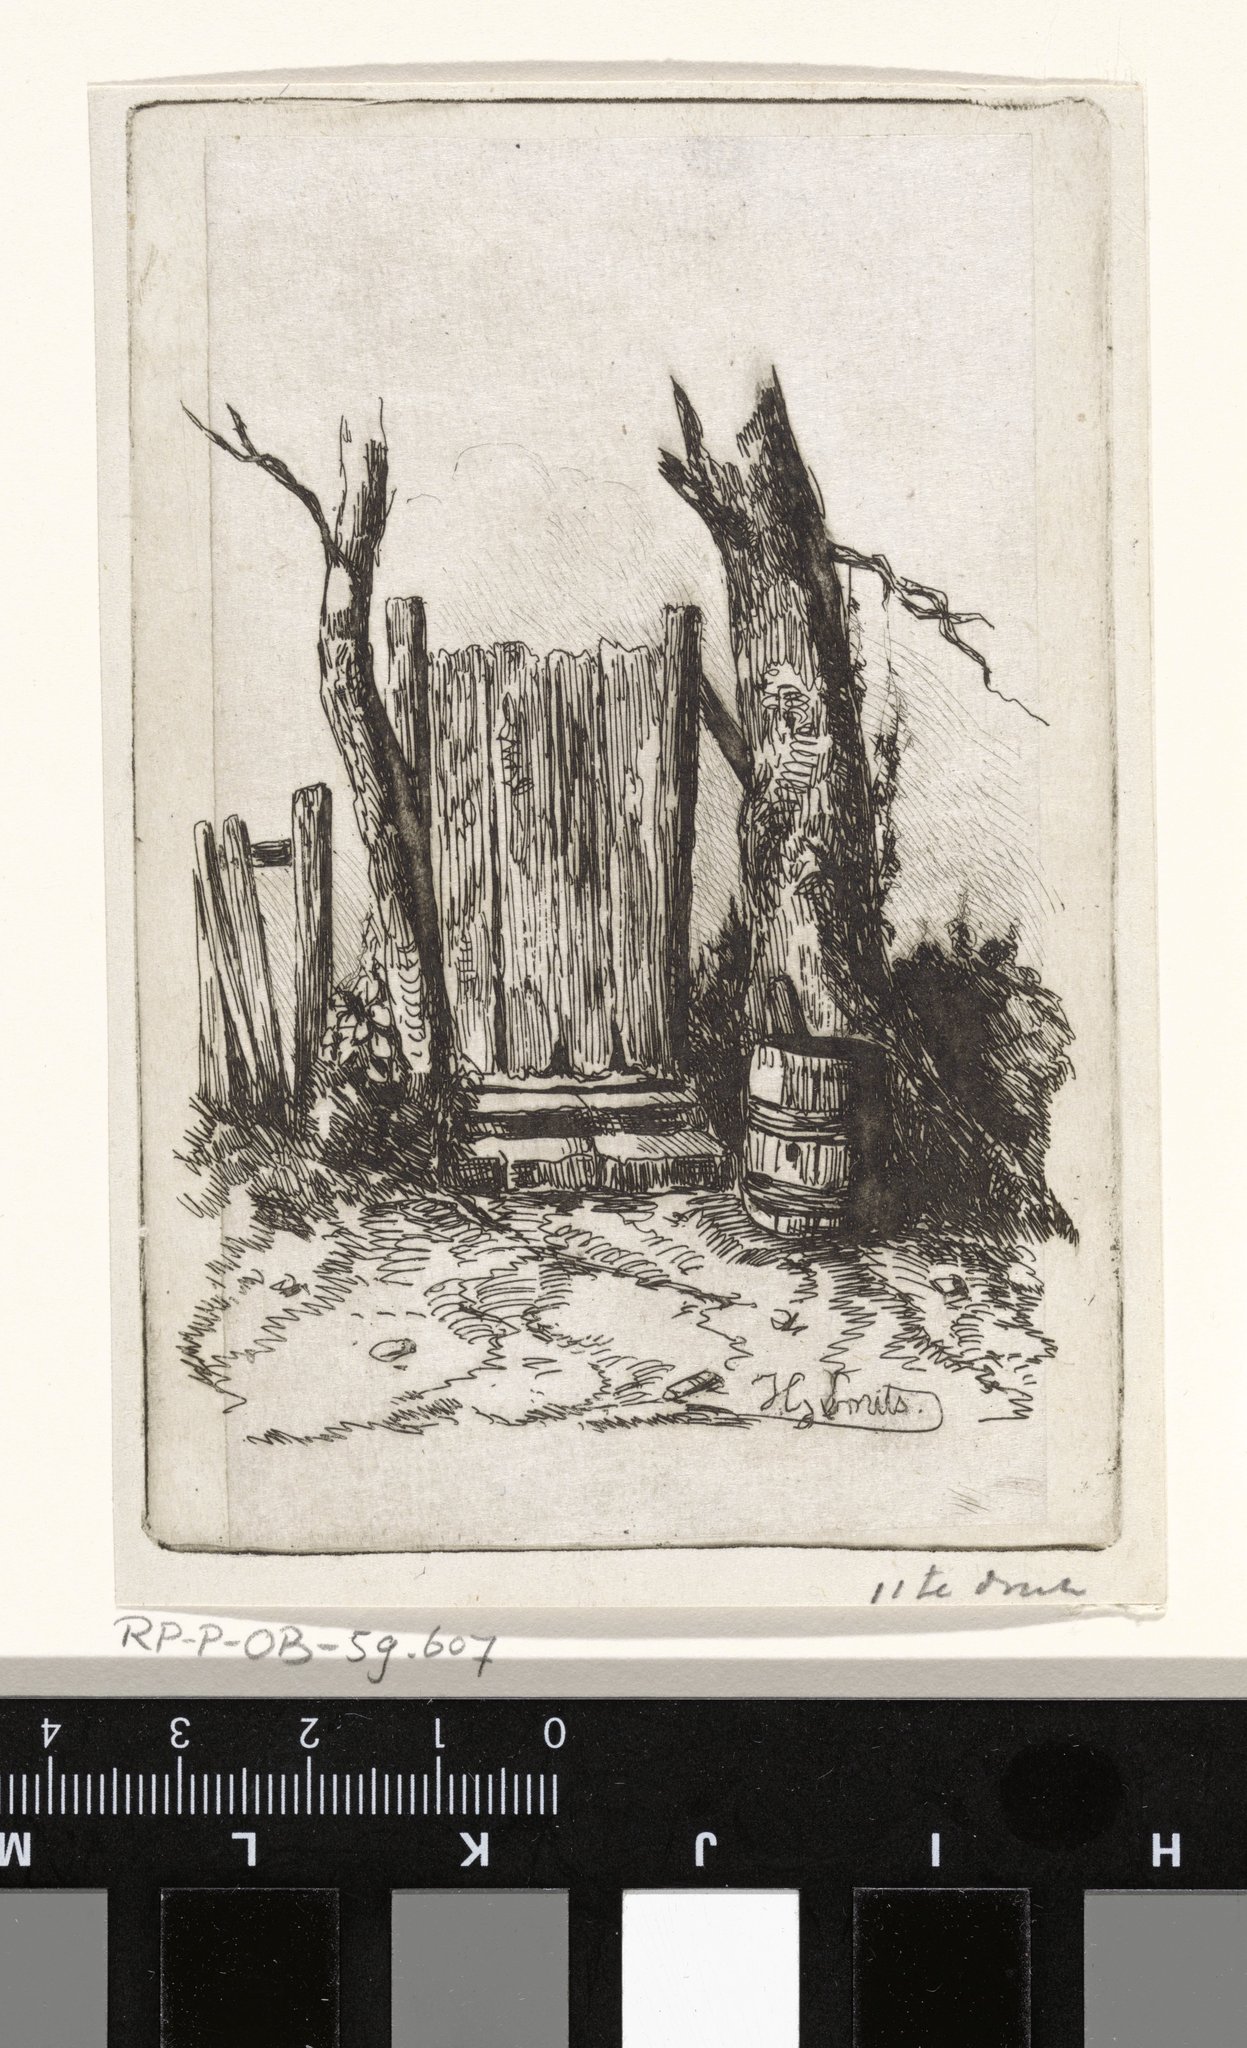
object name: print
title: Houten poortje met regenton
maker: jan gerard smits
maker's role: draughtsman, print maker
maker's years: 1823-1910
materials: paper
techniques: etching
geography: the hague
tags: gate, entrance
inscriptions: collector's mark: Lugt 2228